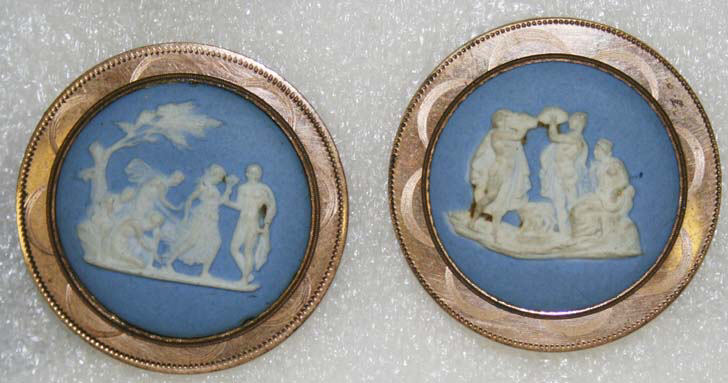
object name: button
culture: british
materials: jasper, metal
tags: cameos,men,women